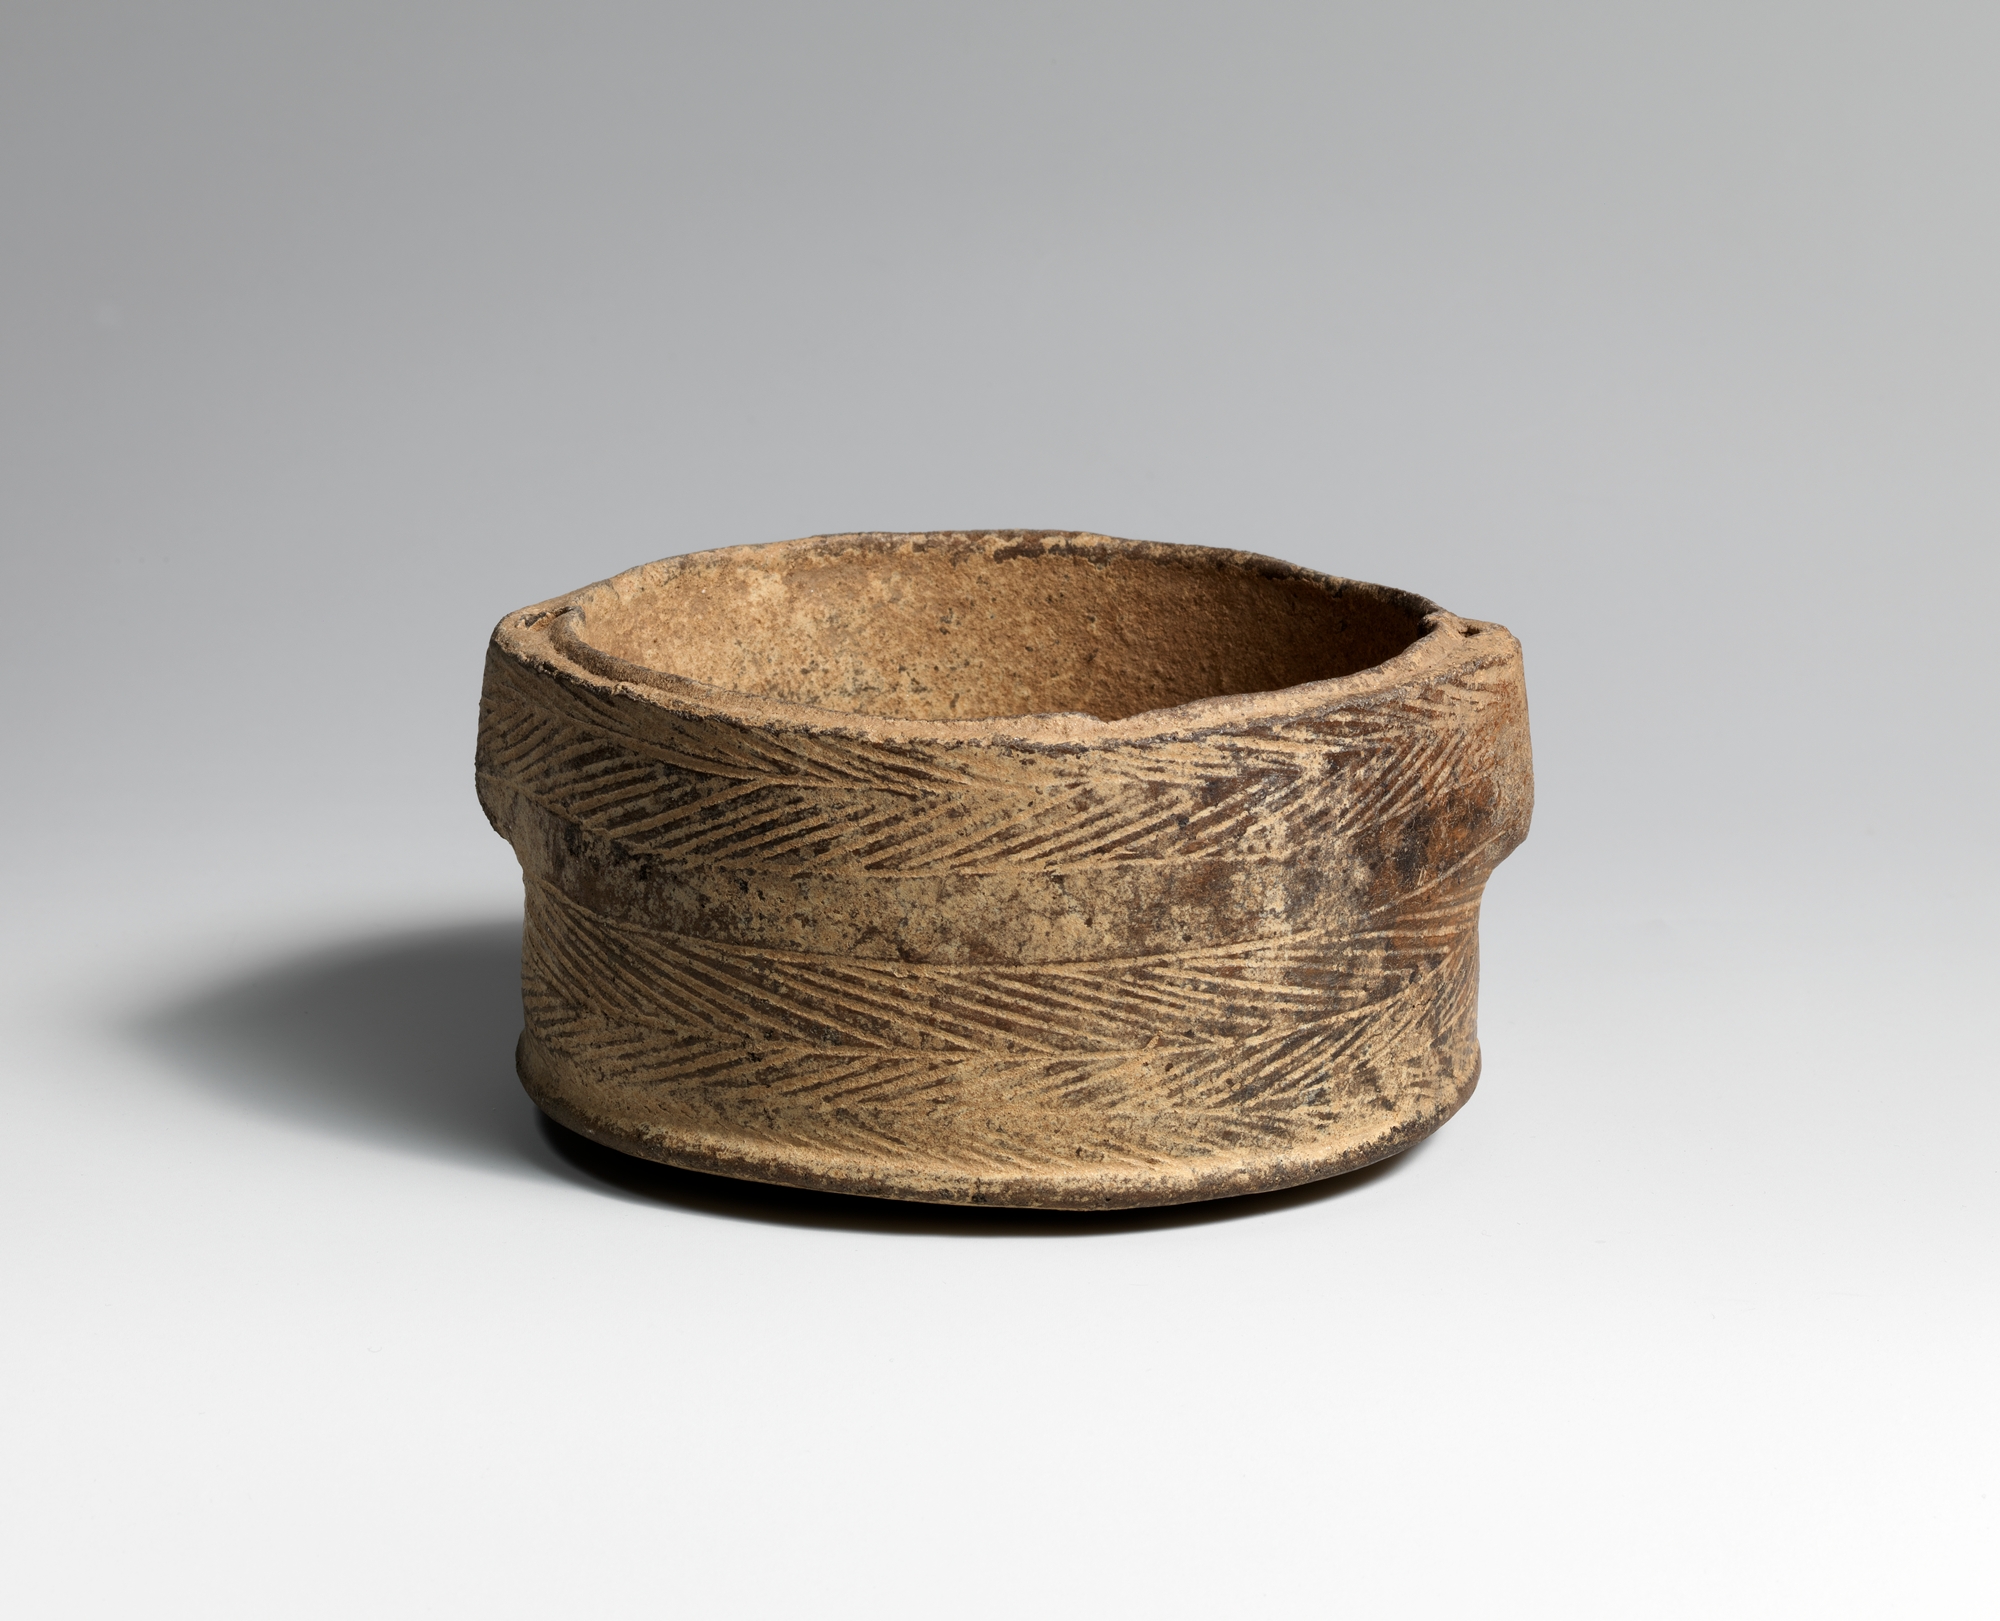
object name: pyxis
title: Terracotta box of a pyxis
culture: cycladic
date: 3200-2800 BCE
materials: terracotta